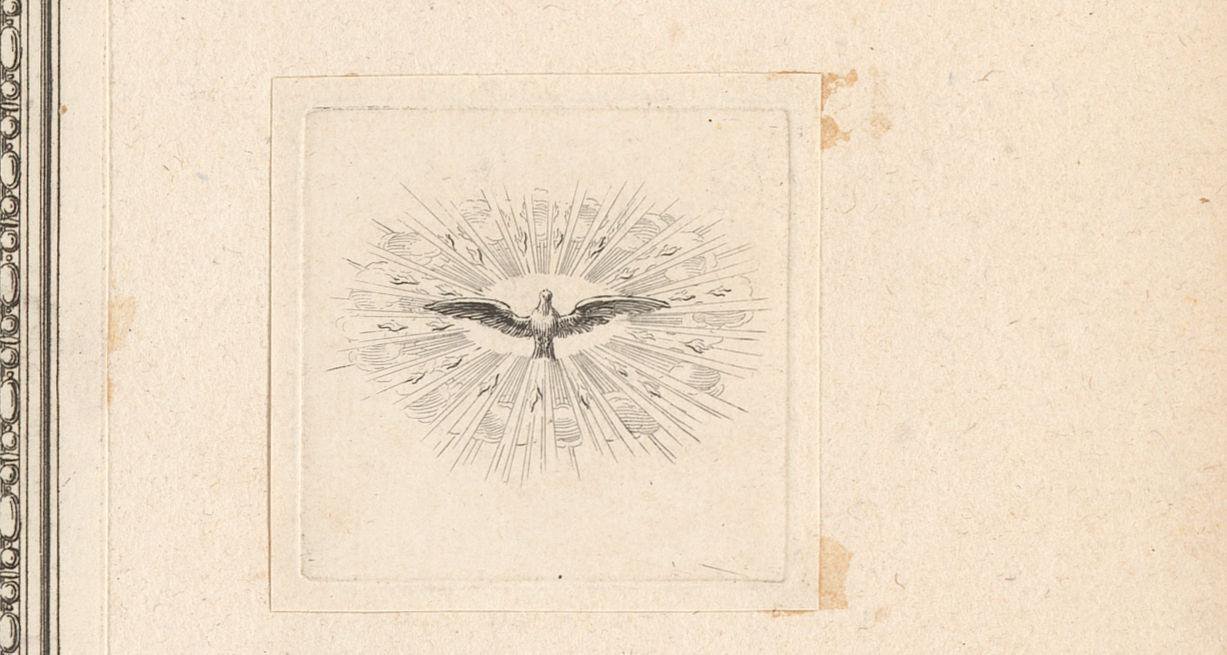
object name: print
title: Cul-de-lampe met de Heilige Geest in de vorm van een duif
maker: sébastien leclerc (i)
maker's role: print maker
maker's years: 1637-1714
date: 1703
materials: paper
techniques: etching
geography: paris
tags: knighthood order of the holy spirit, holy ghost represented as a dove (in flames)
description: Prent gebruikt voor: Office des chevaliers du Saint-Esprit. Parijs: Imprimerie Royale, 1703.